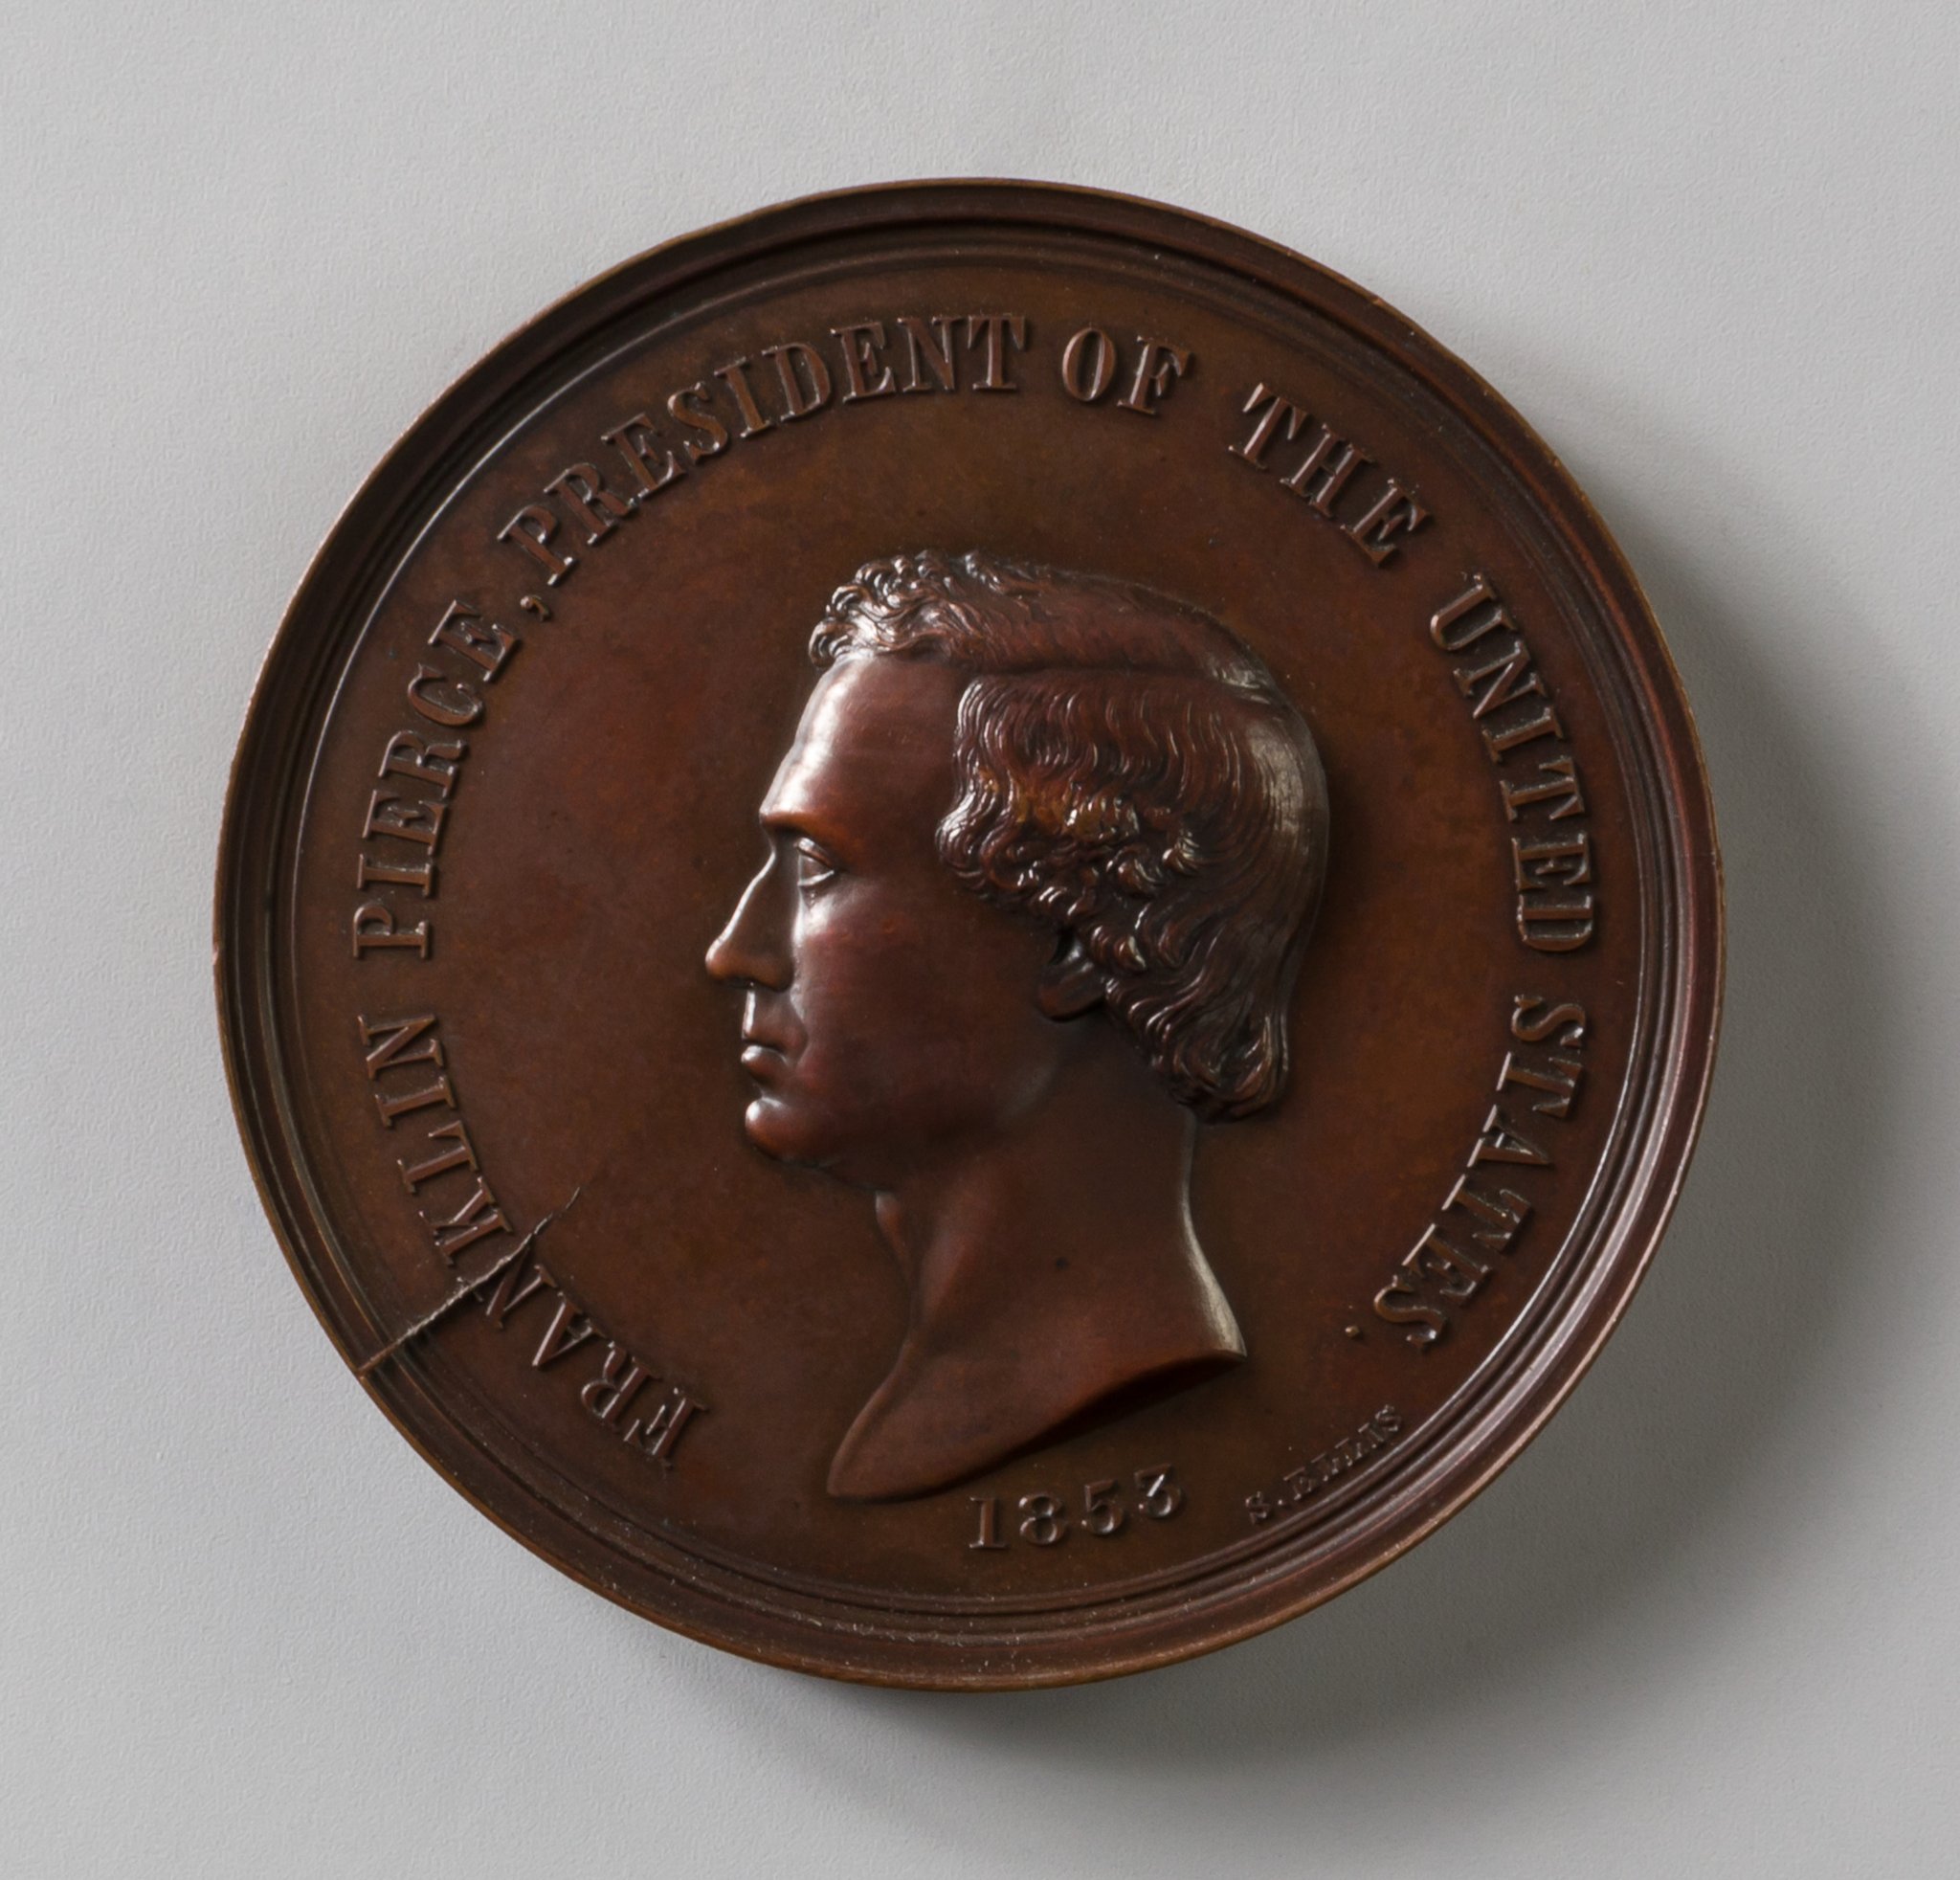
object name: medal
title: Medal of Franklin Pierce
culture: american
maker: salathiel ellis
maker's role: maker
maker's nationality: american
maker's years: 1803-1879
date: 1853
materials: bronze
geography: united states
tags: men,profiles